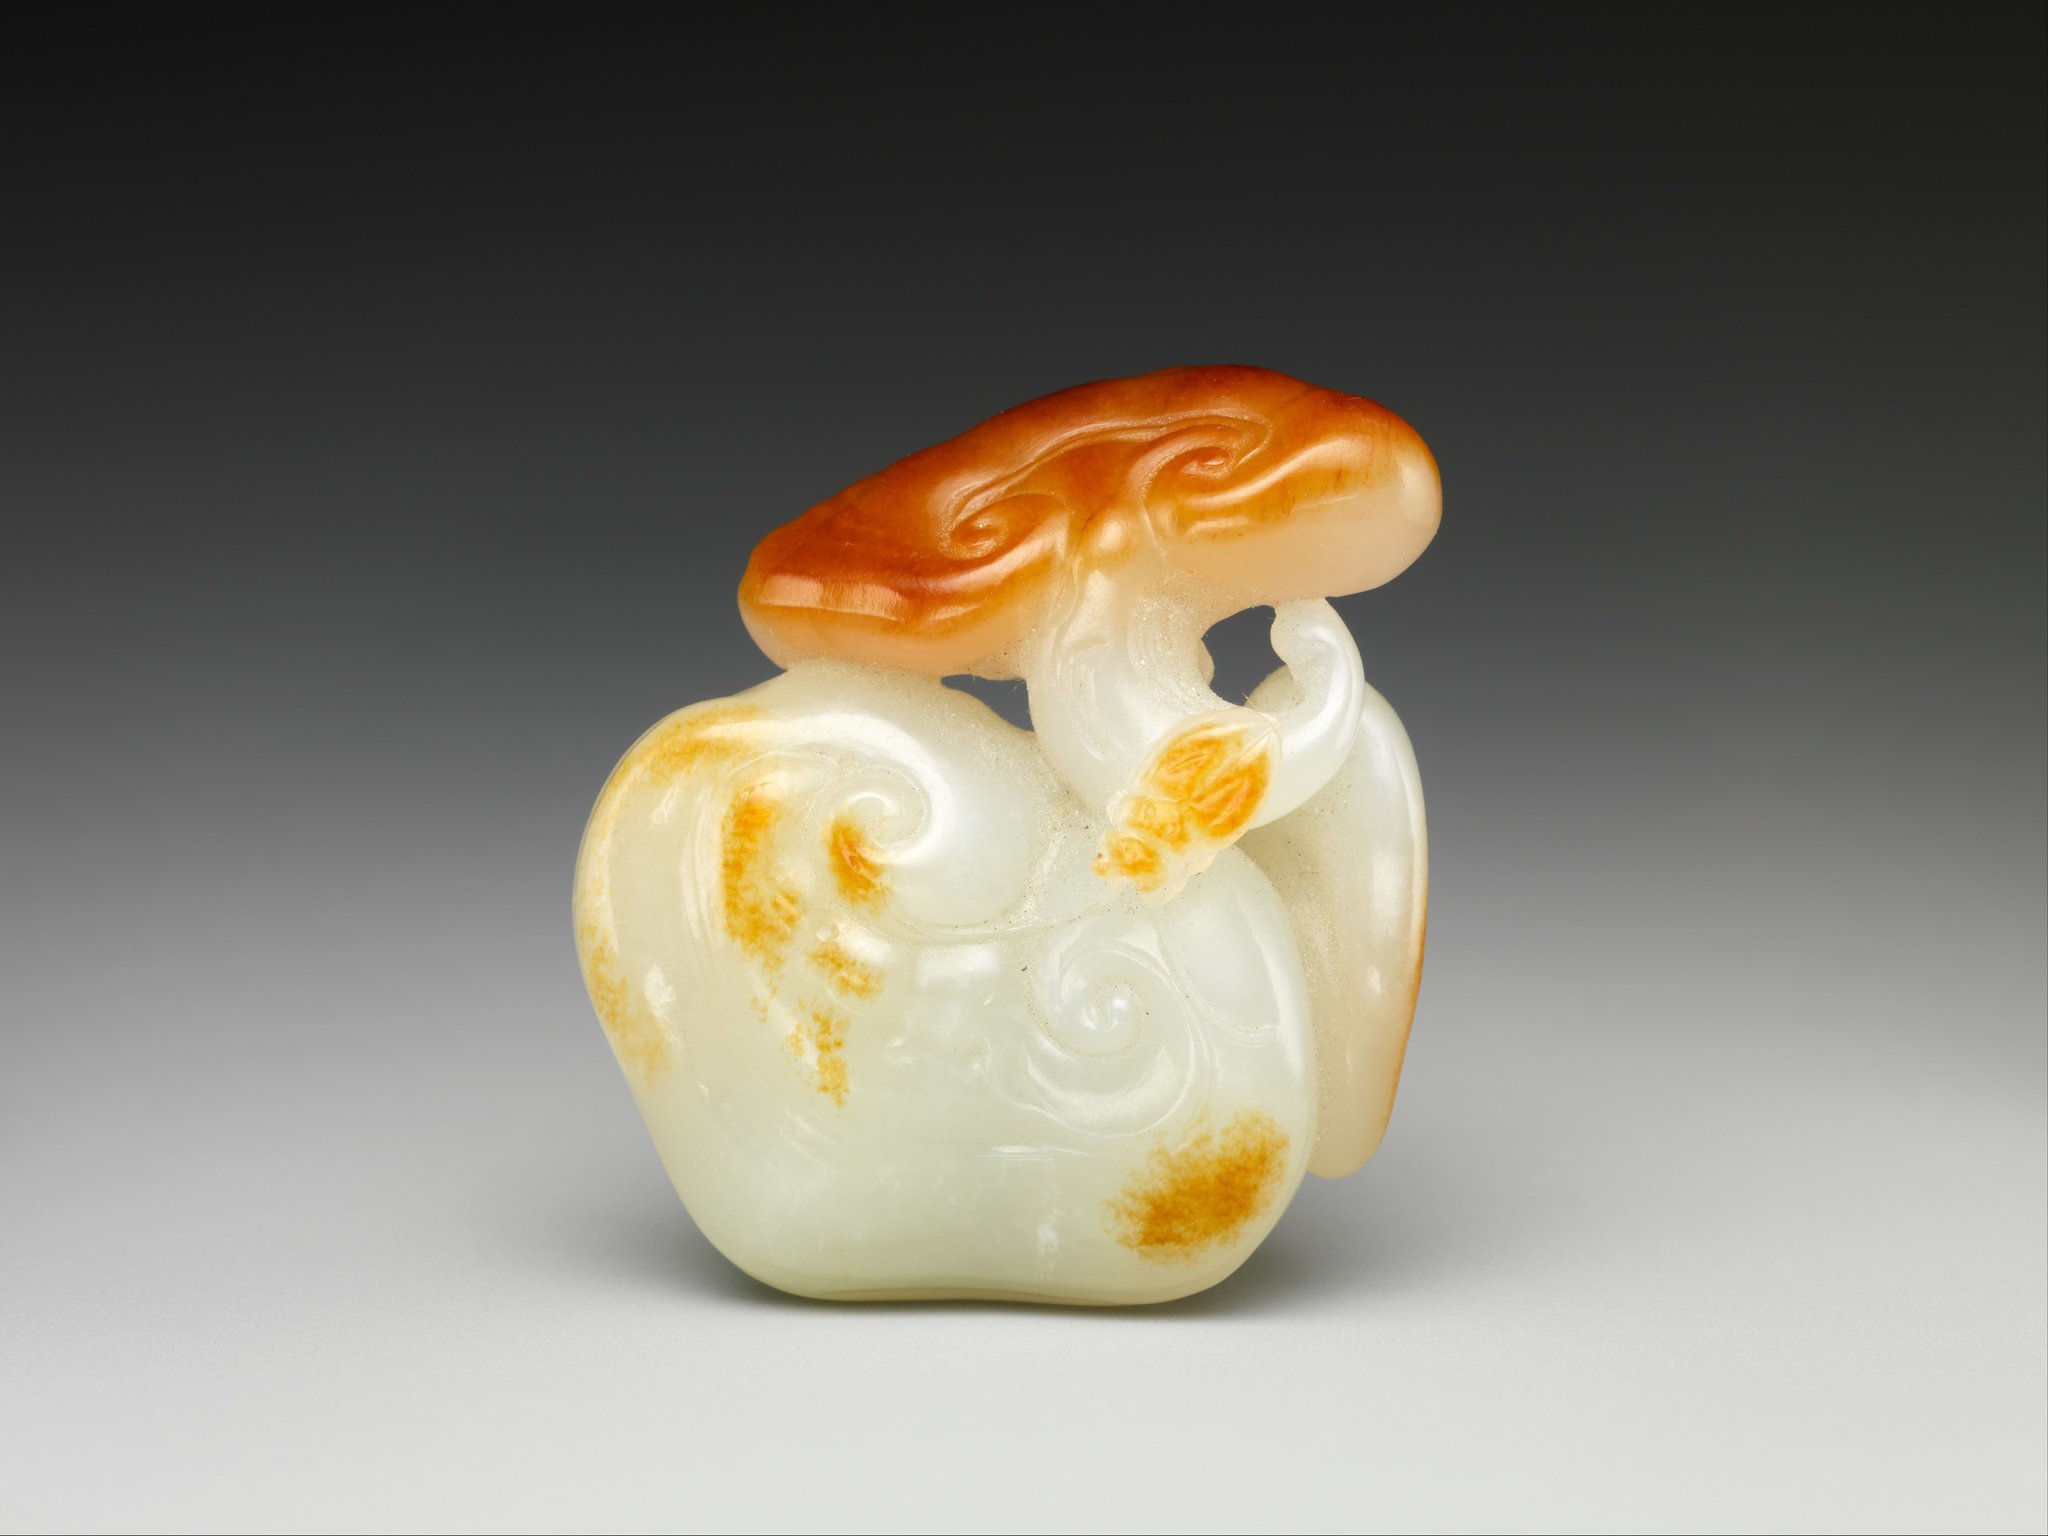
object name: ornament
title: Lingzhi mushrooms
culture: chinese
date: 1701-1800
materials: jade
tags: vegetables